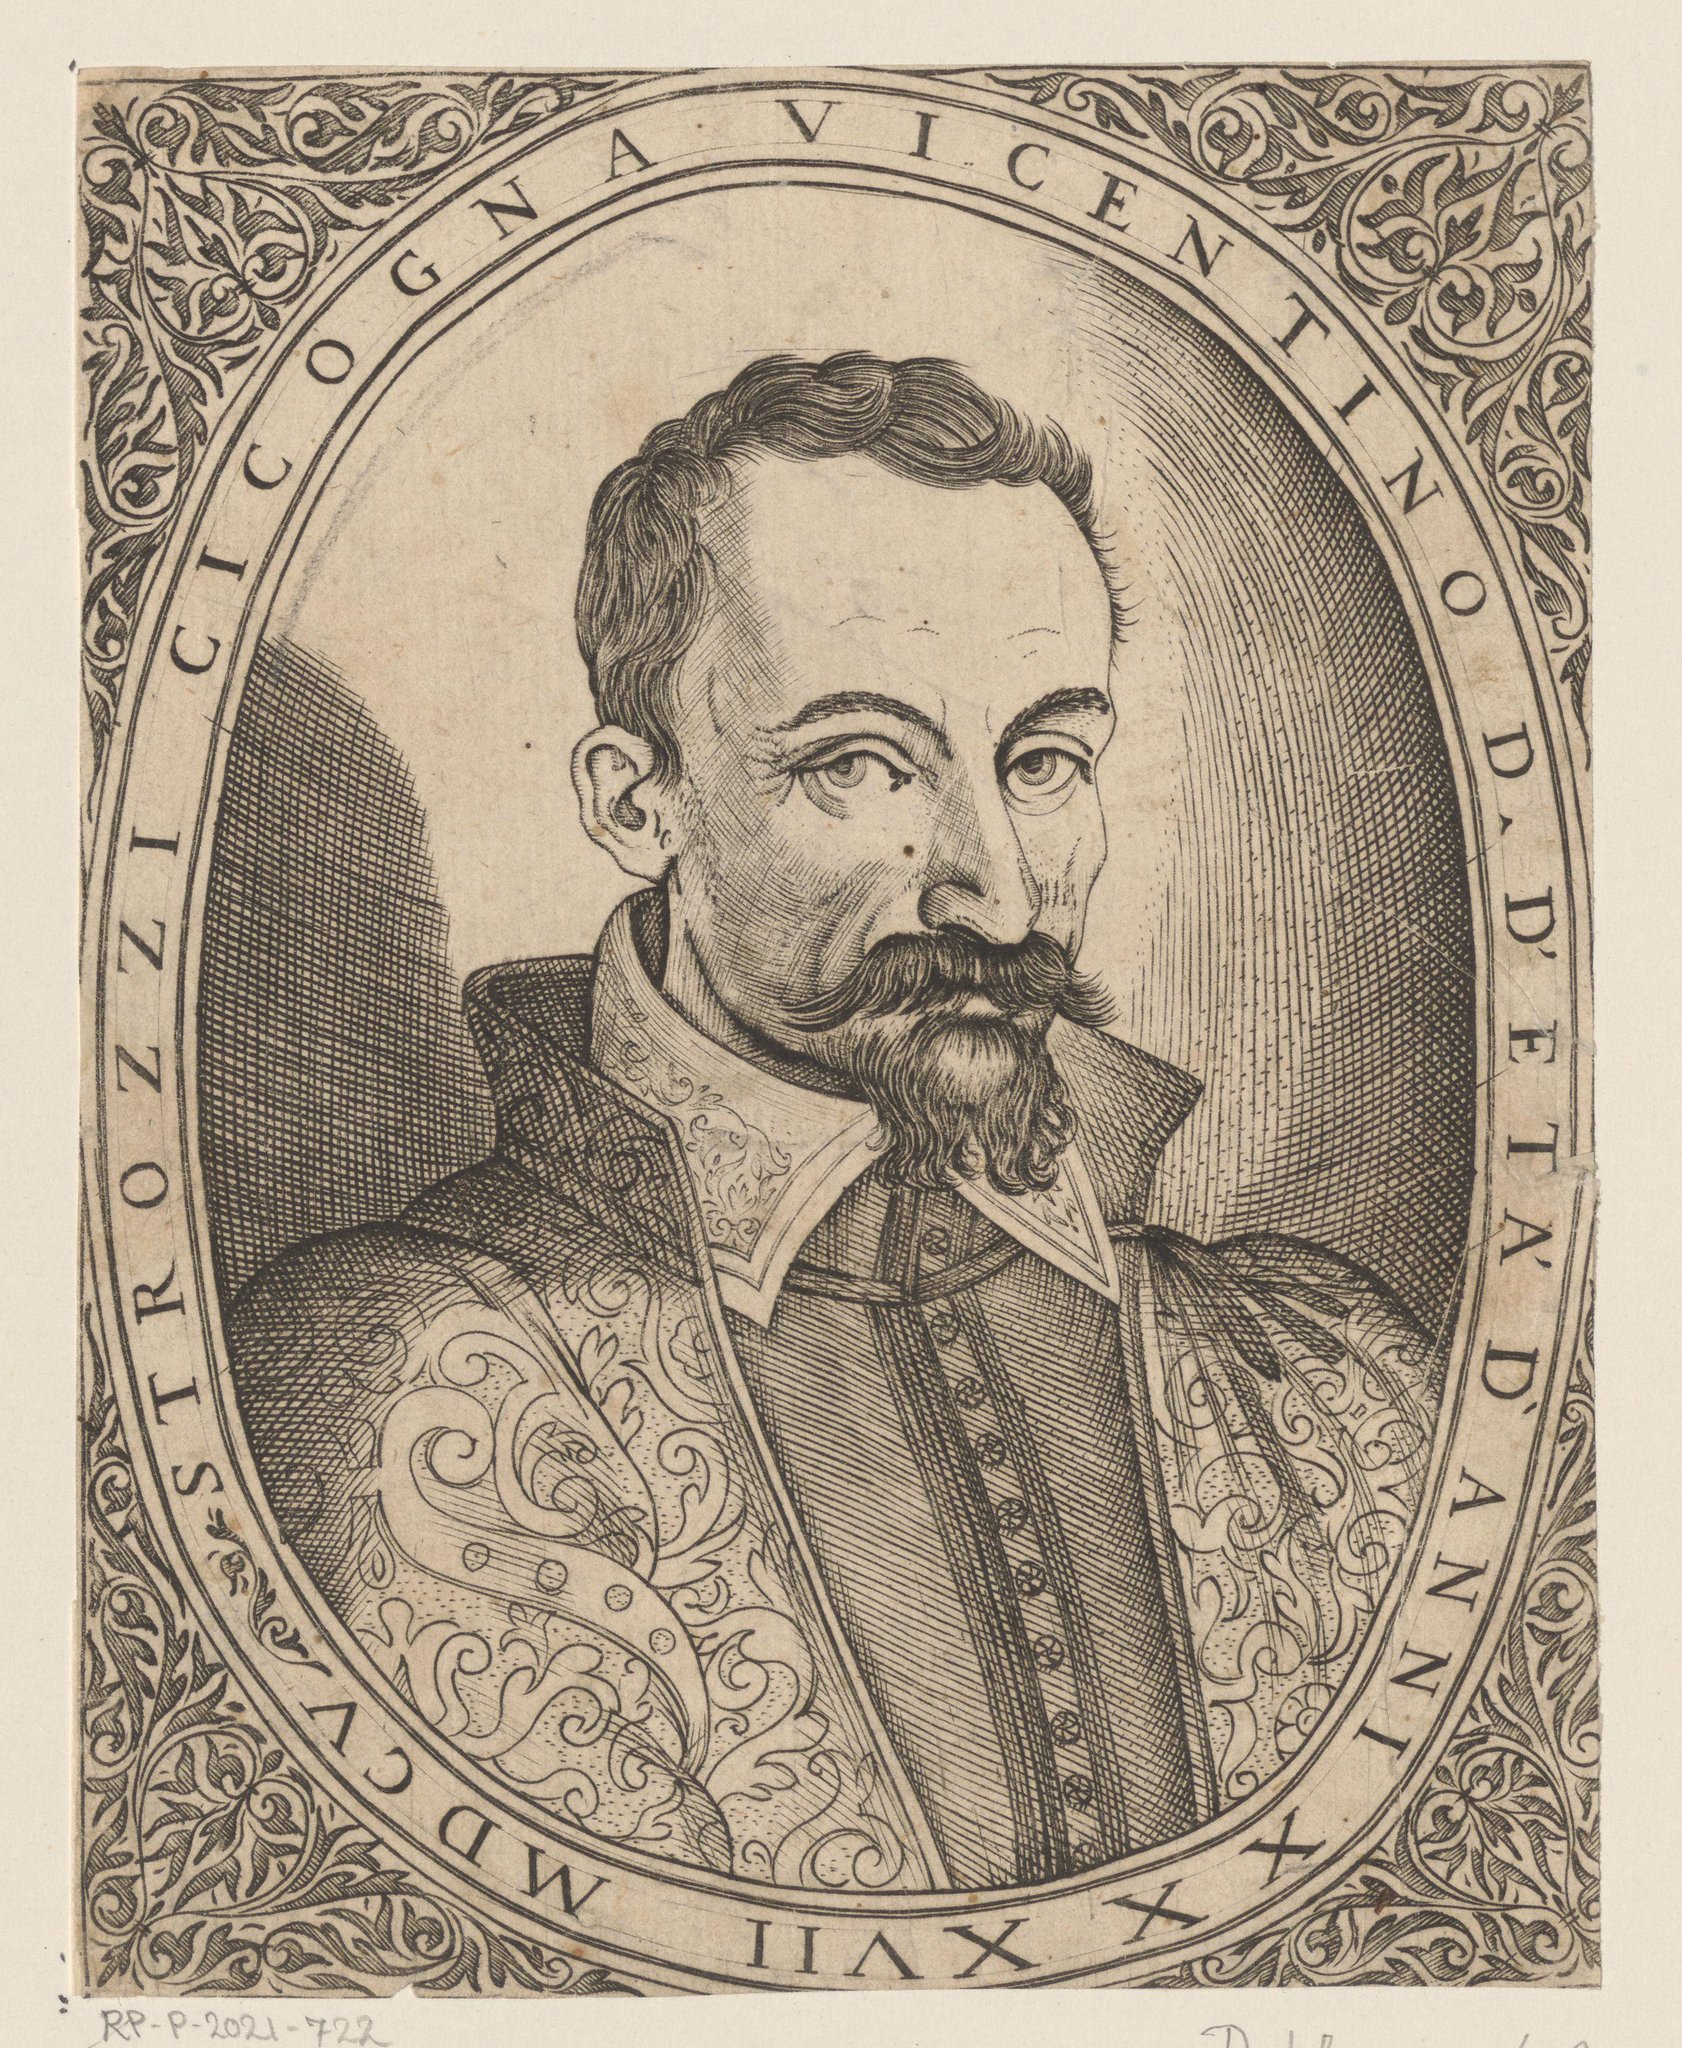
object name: print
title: Portret van Strozzi Cicogna op 37-jarige leeftijd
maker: Anonymous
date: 1605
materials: paper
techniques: engraving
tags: historical persons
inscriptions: date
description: Prent mogelijk uit: Cicogna, Strozzi. Palagio de gl'incanti (...). Venetië: Roberto Meglietti, 1605.